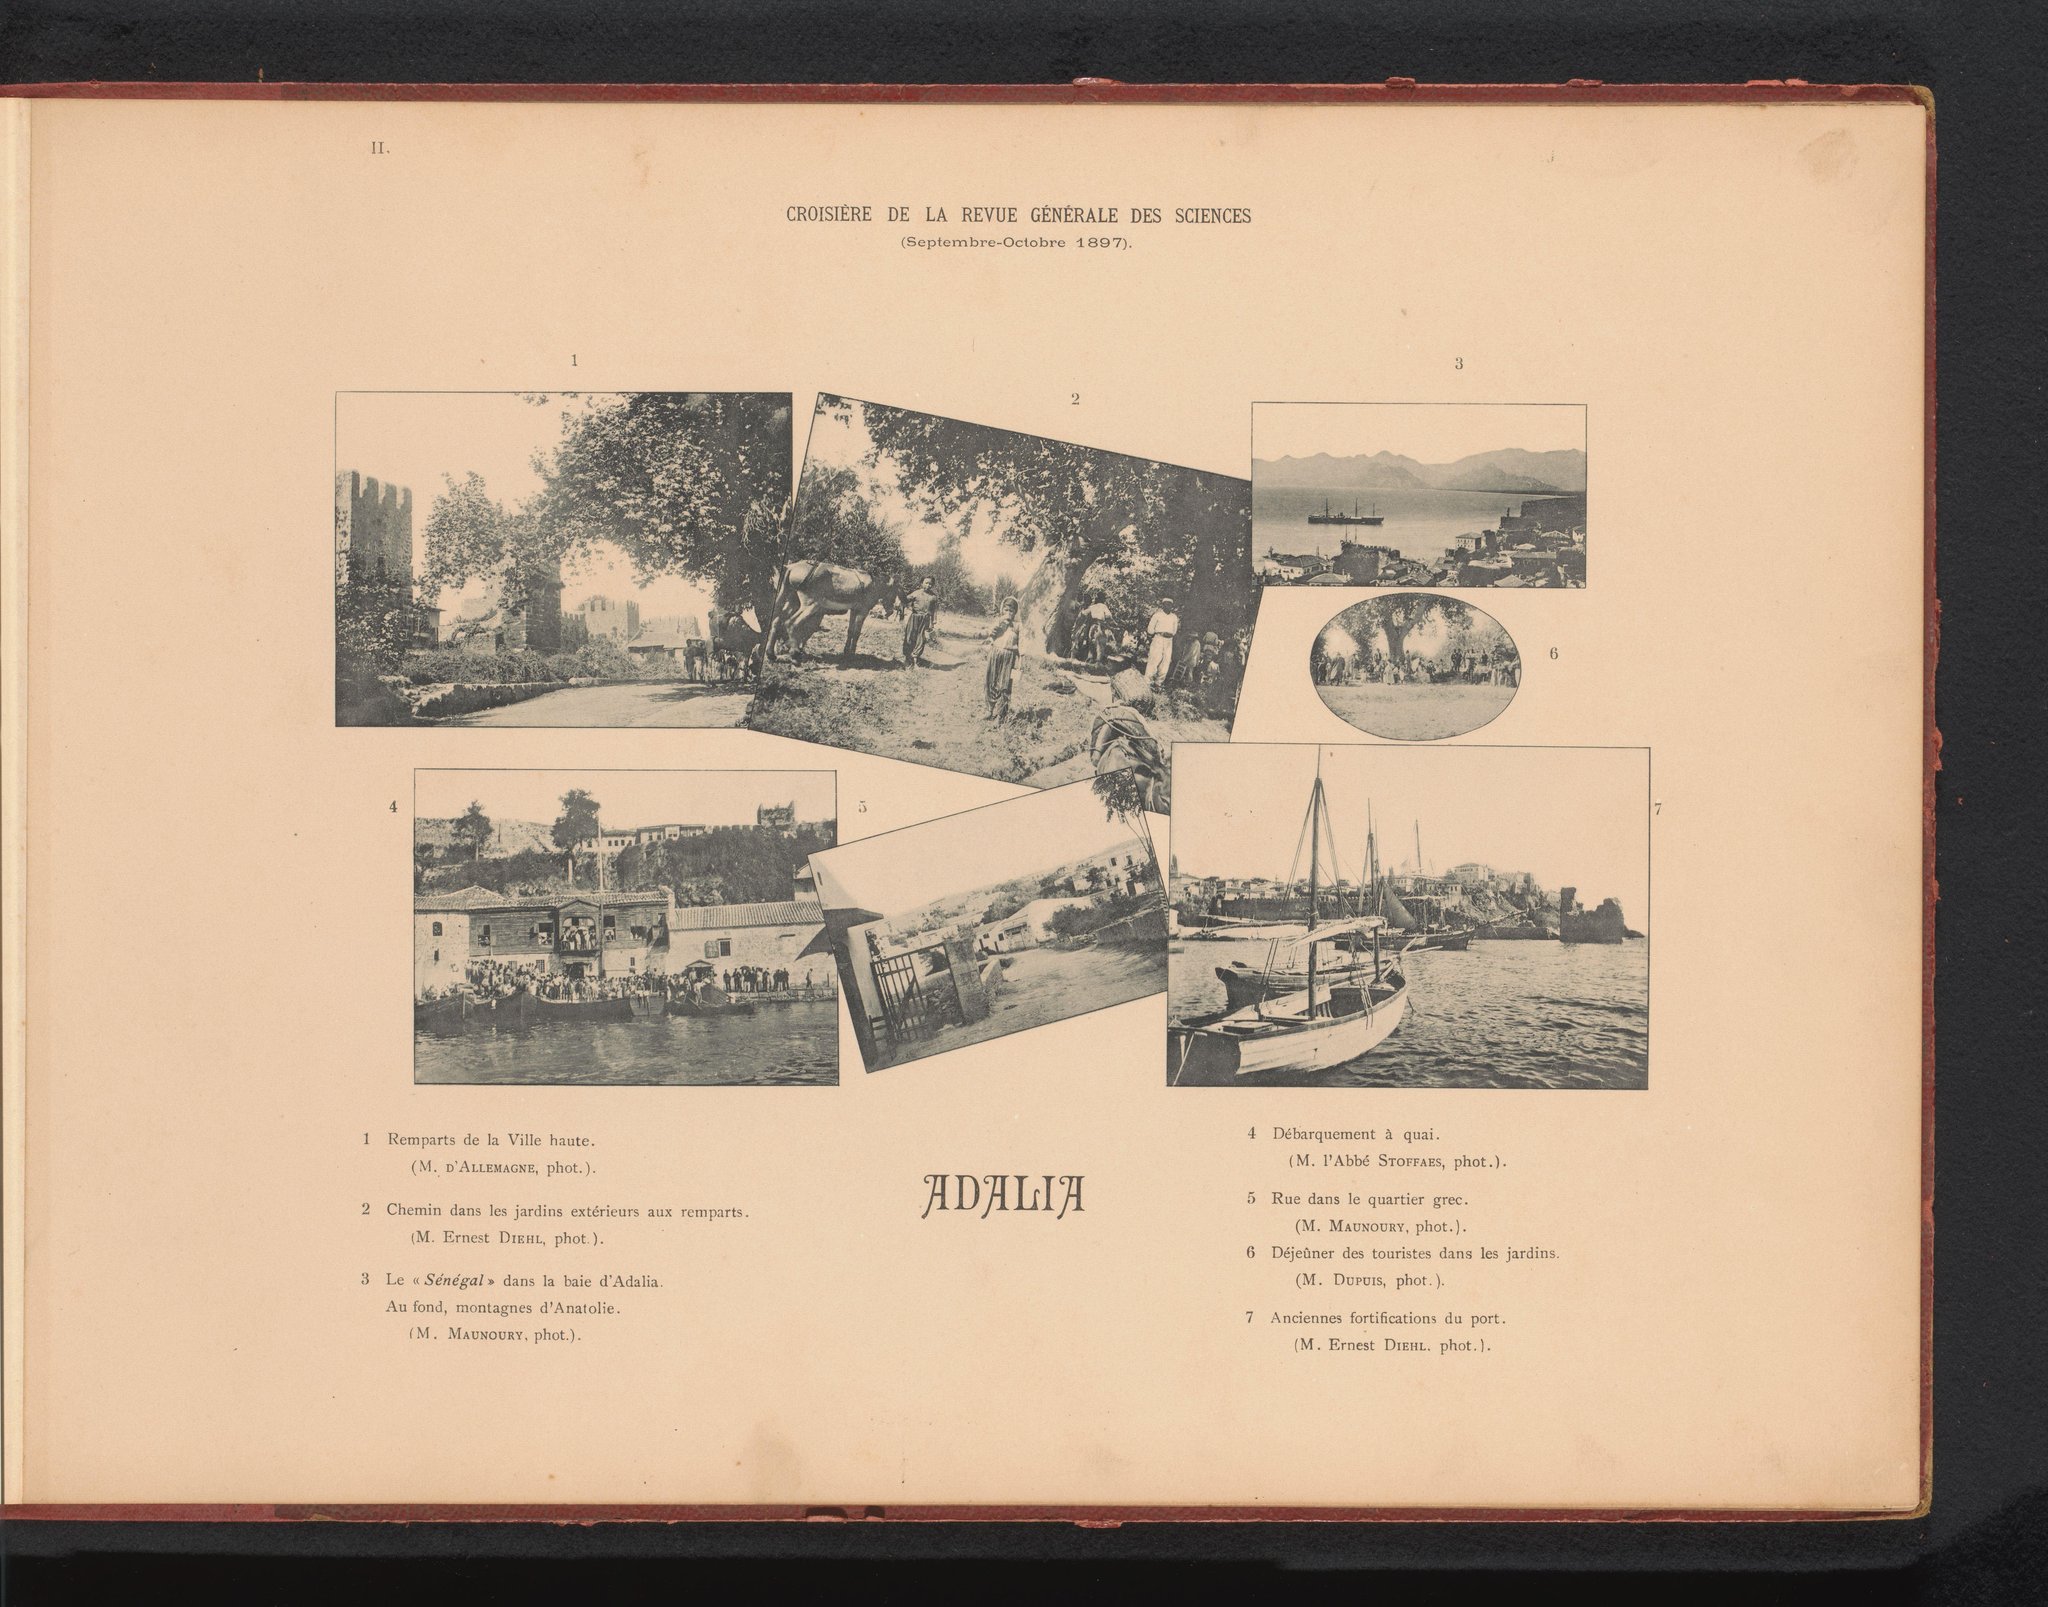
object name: page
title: Zeven gezichten op Adalia, Spanje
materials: paper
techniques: photograph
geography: adalia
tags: castle, coast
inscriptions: number: ‘II.’, inscription: ‘1 Remparts de la Ville haute./ (M. d'Allemagne, phot.)./ 2 Chemin dans les jardins extérieurs aux remparts./ (M. Ernest Diehl, phot.)./ 3 Le << Sénégal >> dans la baie d'Adalia./ Au fond, montagnes d'Anatolie./ (M. Maunoury, phot.)./ 4 Débarquement à quai./ (M. l'Abbé Stoffaes, phot.)./ 5 Rue dans le quartier grec./ (M. Maunoury, phot.)./ 6 Déjeûner des touristes dans les jardins./ (M. Dupuis, phot.)./ 7 Anciennes fortifications du port./ (M. Ernest Diehl, phot.).’